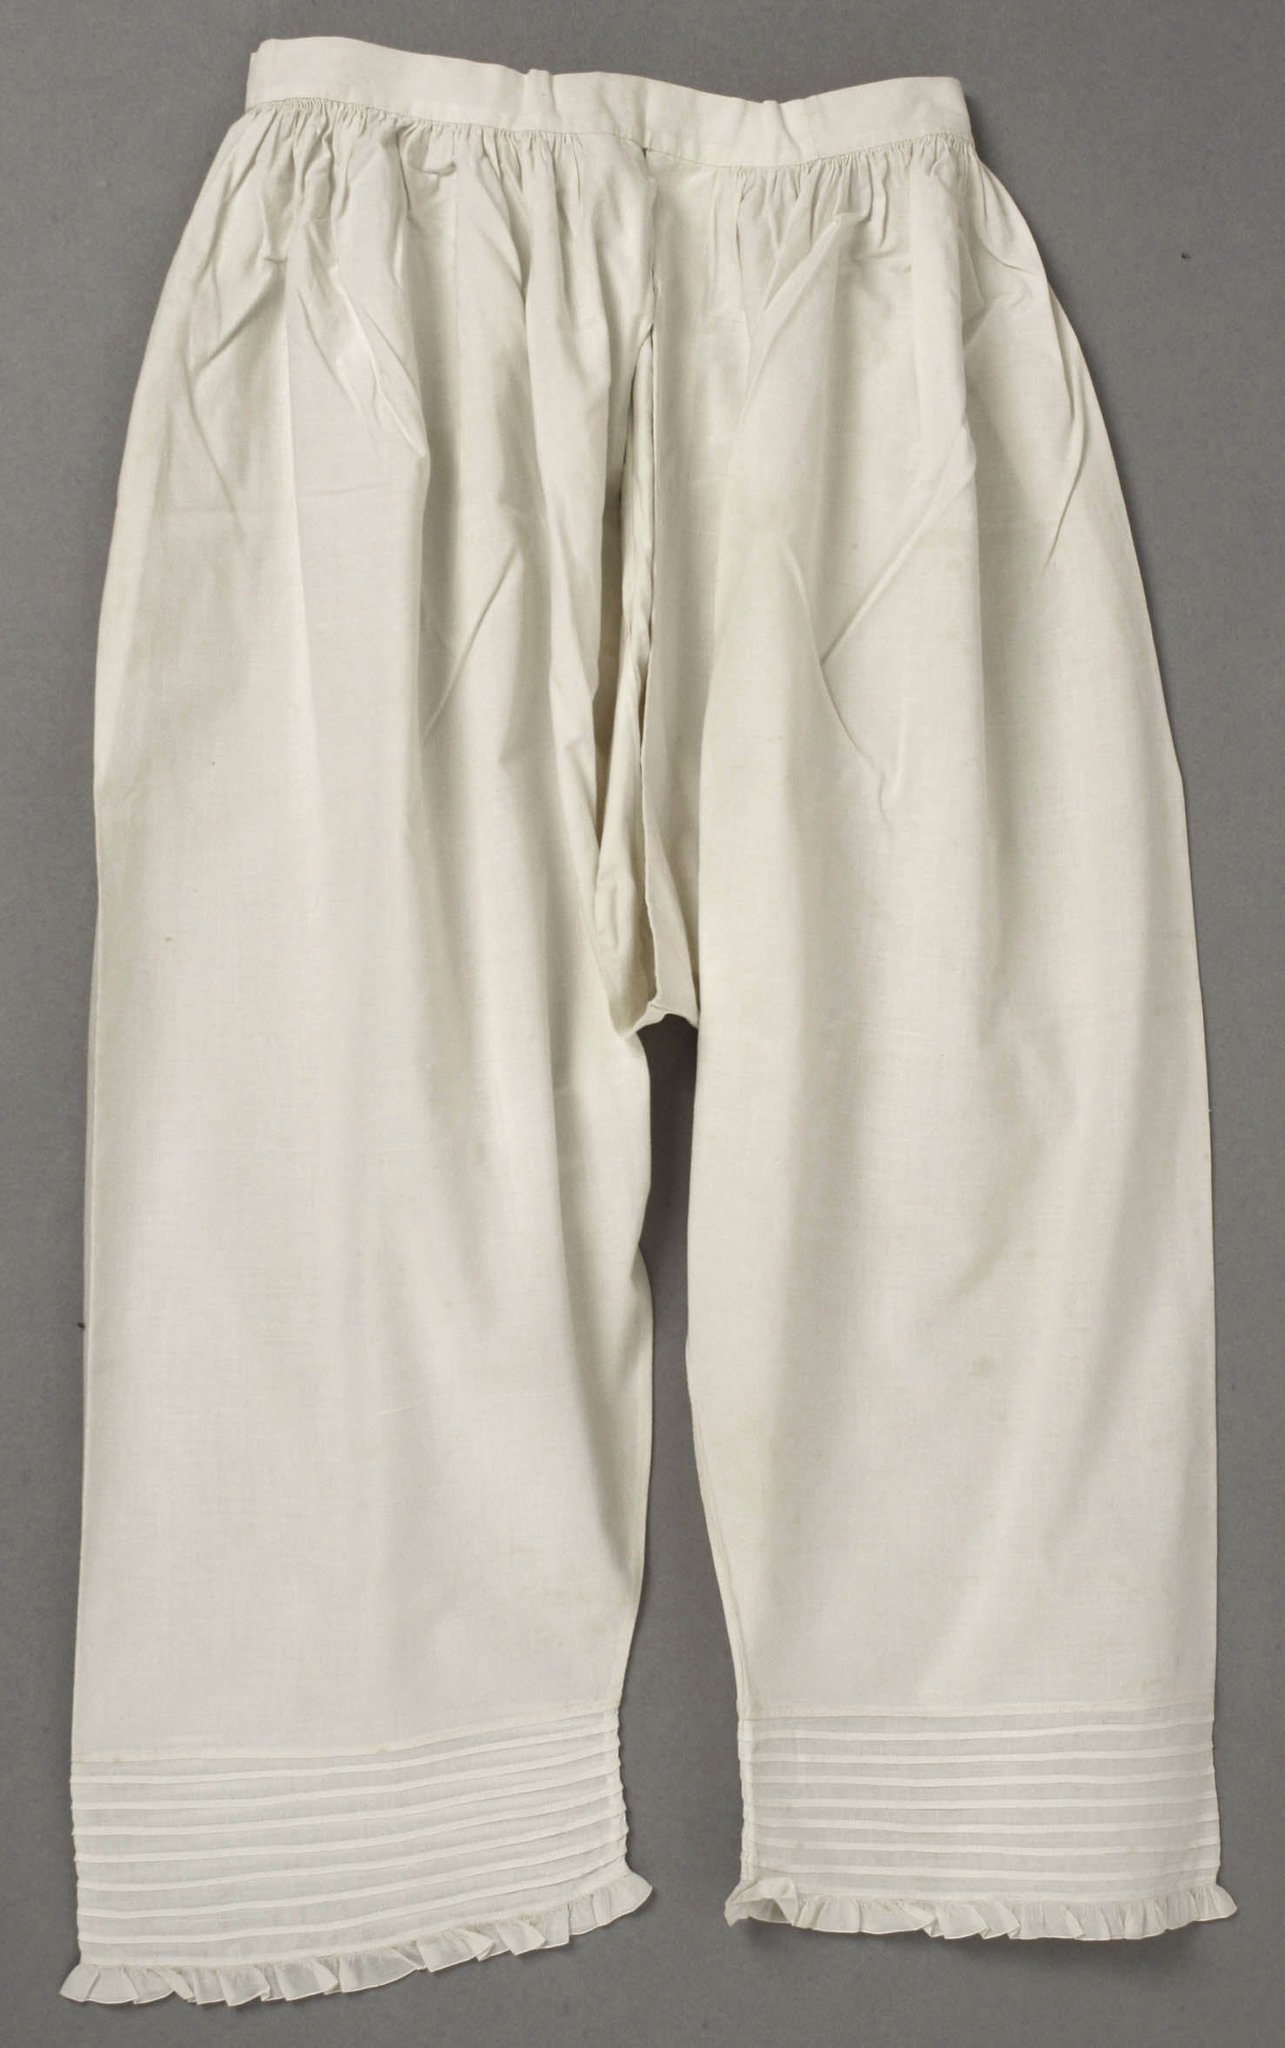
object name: drawer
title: Drawers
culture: american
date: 1866